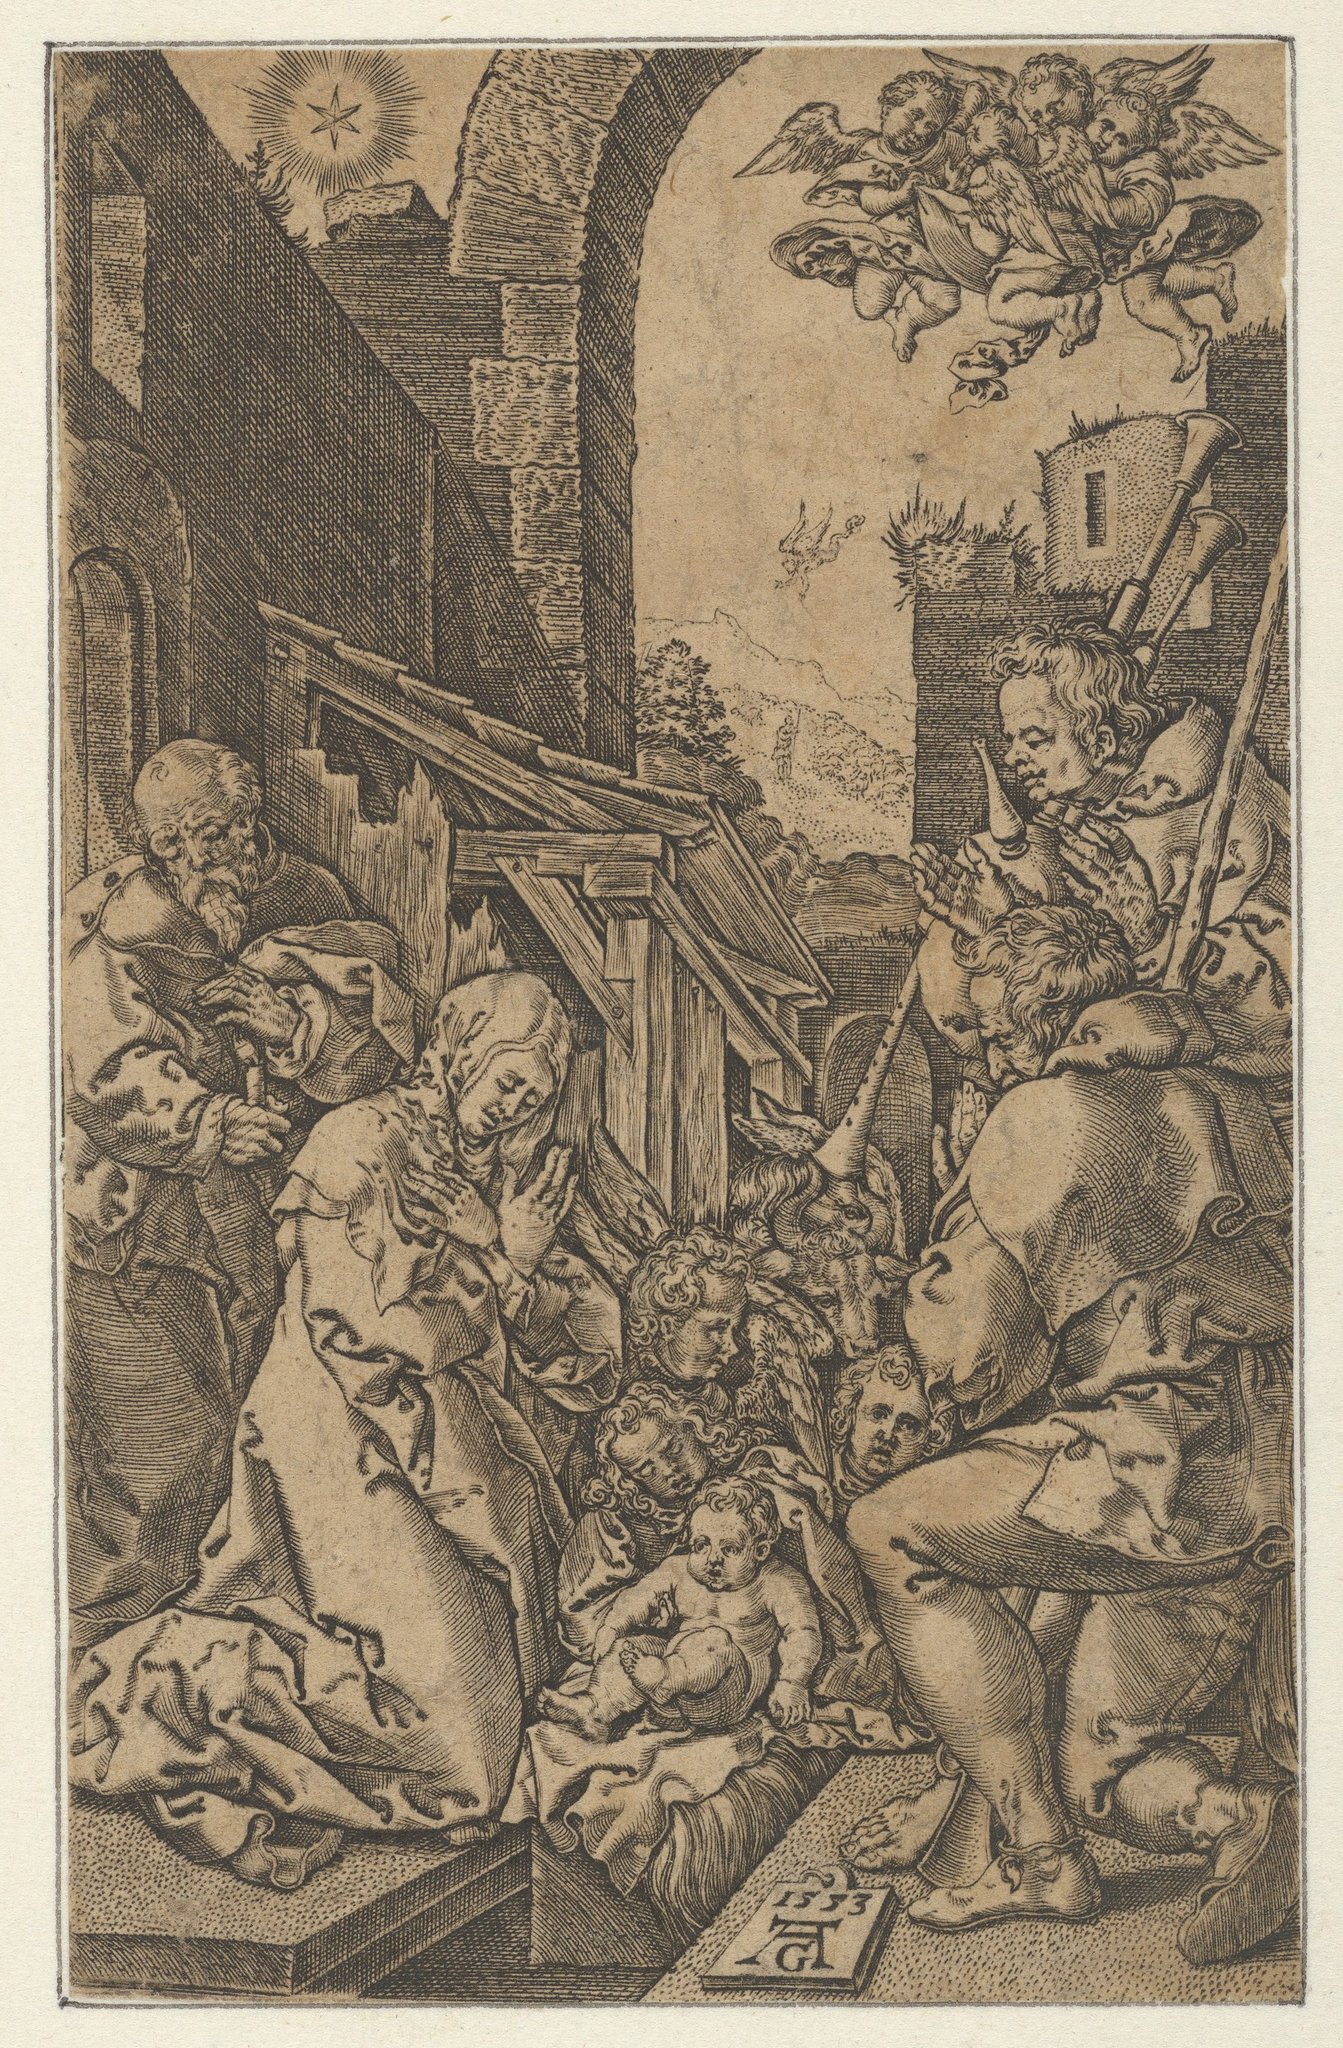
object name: print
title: Copy of The Adoration of the Shepherds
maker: heinrich aldegrever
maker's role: artist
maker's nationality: german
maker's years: 1502-1561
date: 1553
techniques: engraving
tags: angels,christ,virgin mary,adoration of the shepherds